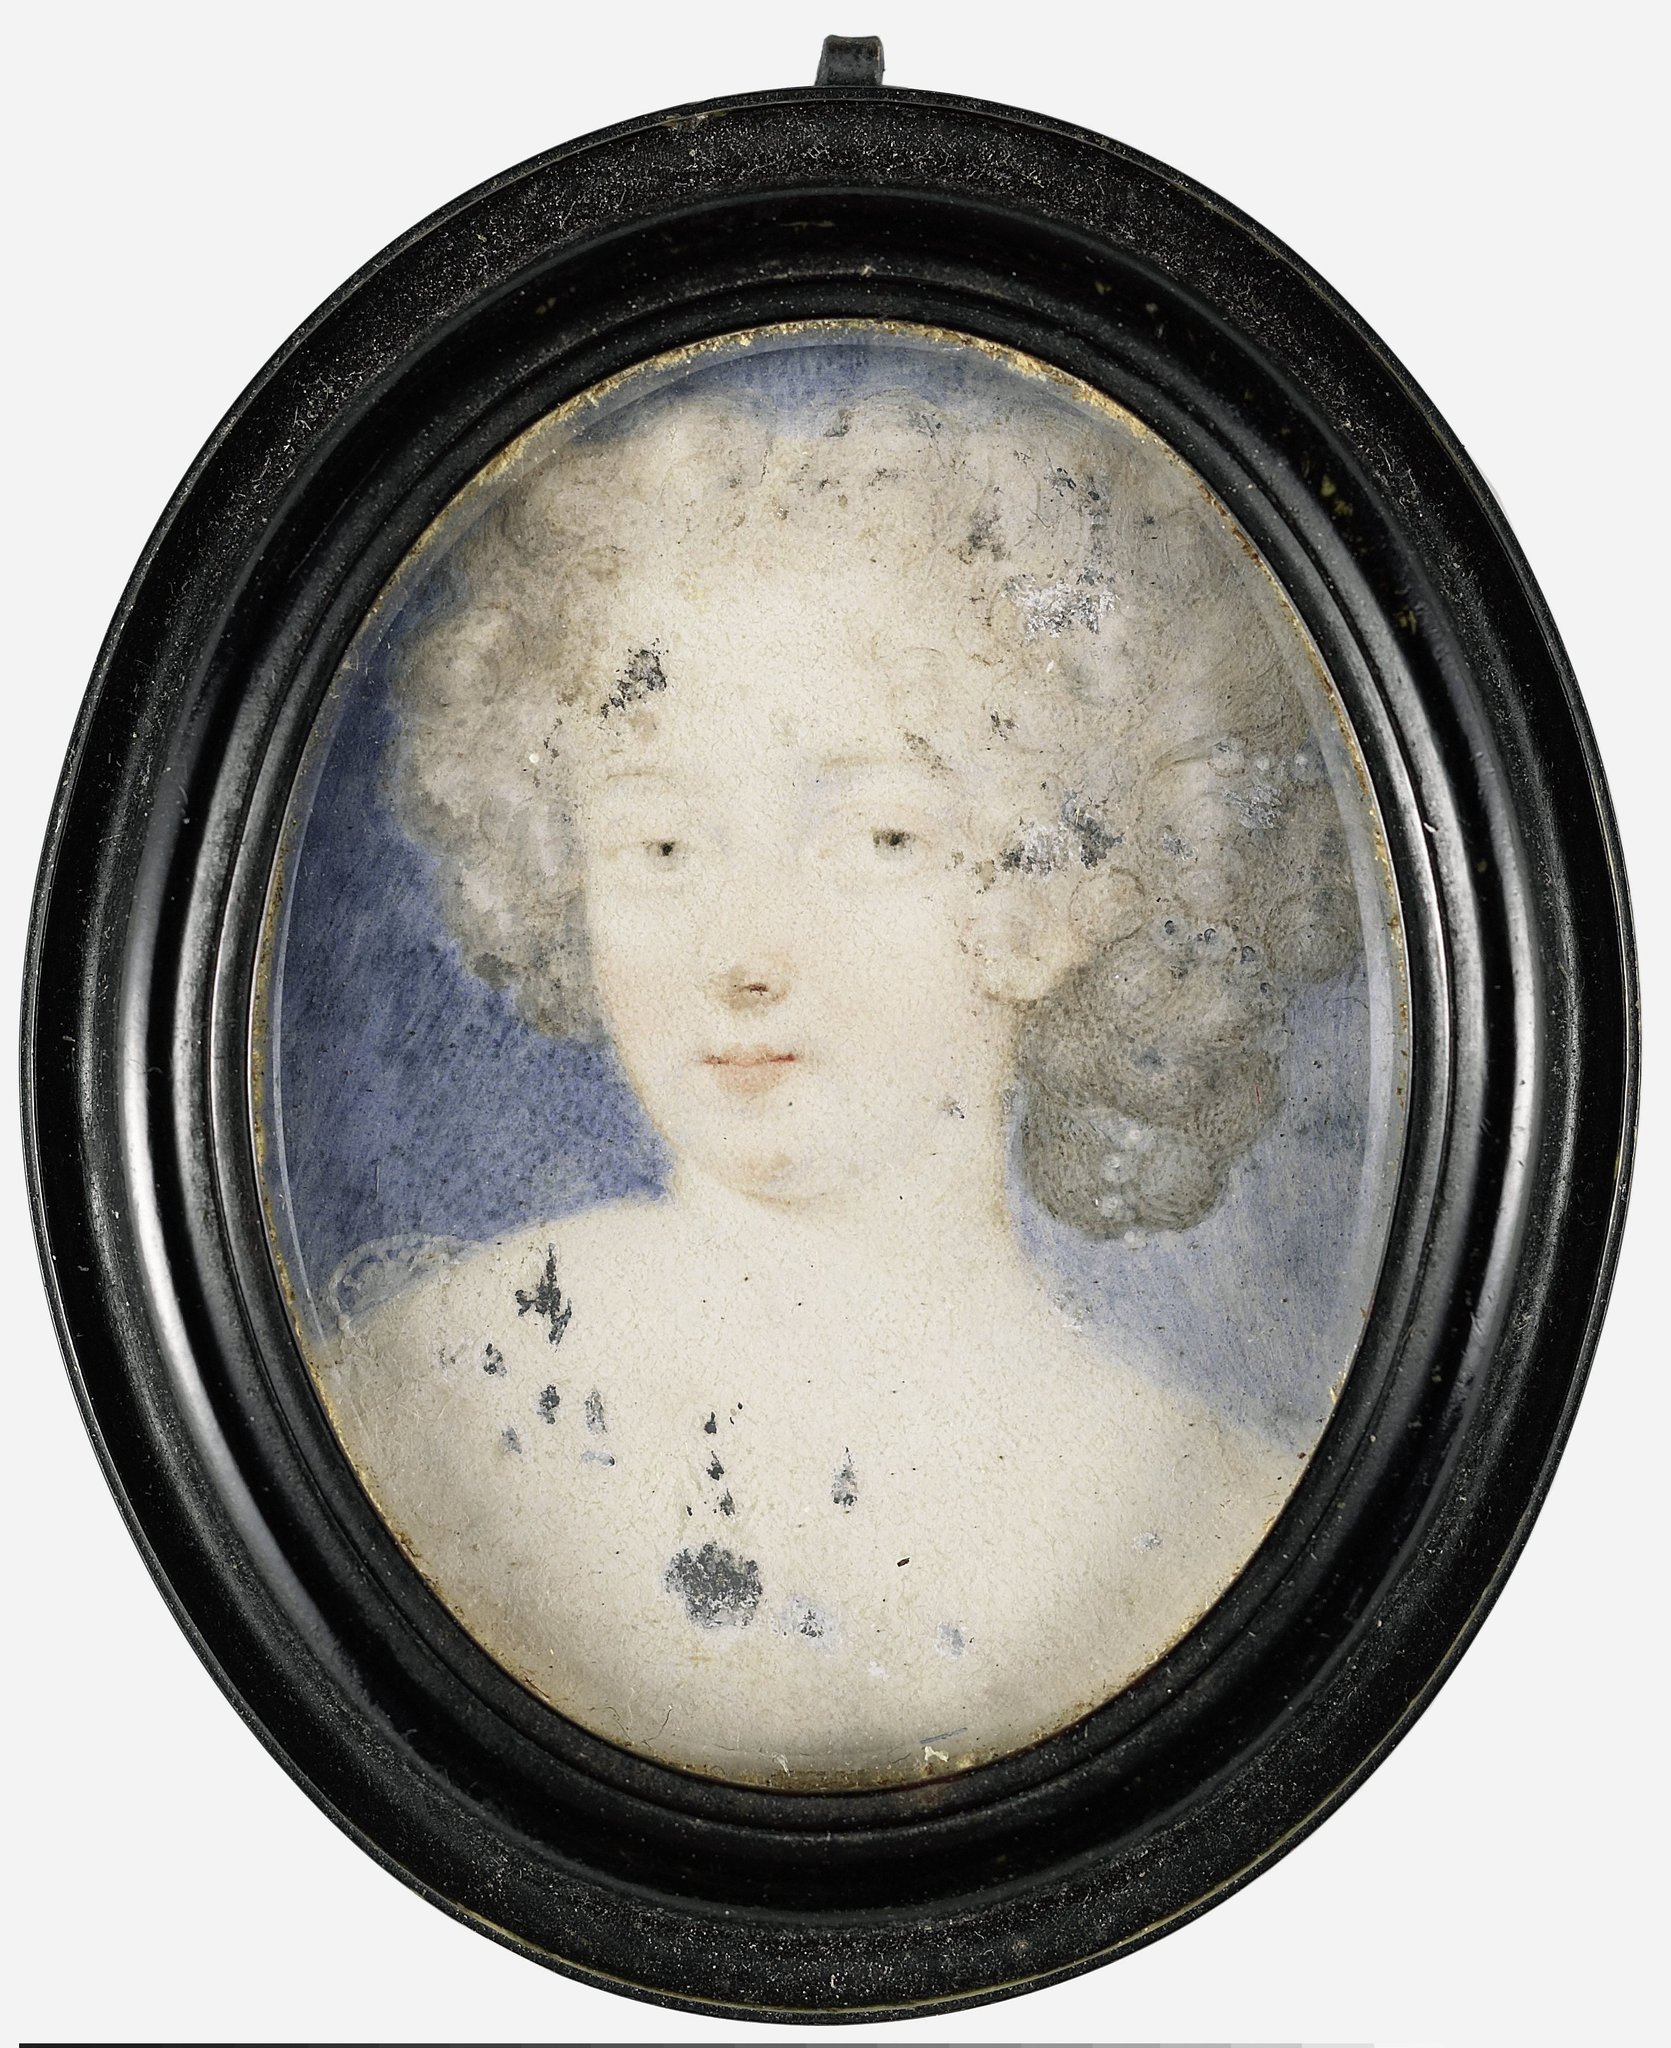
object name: painting, miniature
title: Hortense Mancini (1646-1699), hertogin van Mazarin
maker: Anonymous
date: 1665-1685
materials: glass, parchment, wood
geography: france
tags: hortense mancini hertogin van mazarin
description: Portret van Hortense Mancini (1646-1699), hertogin van Mazarin. Buste, aanziend. Onderdeel van de collectie portretminiaturen.